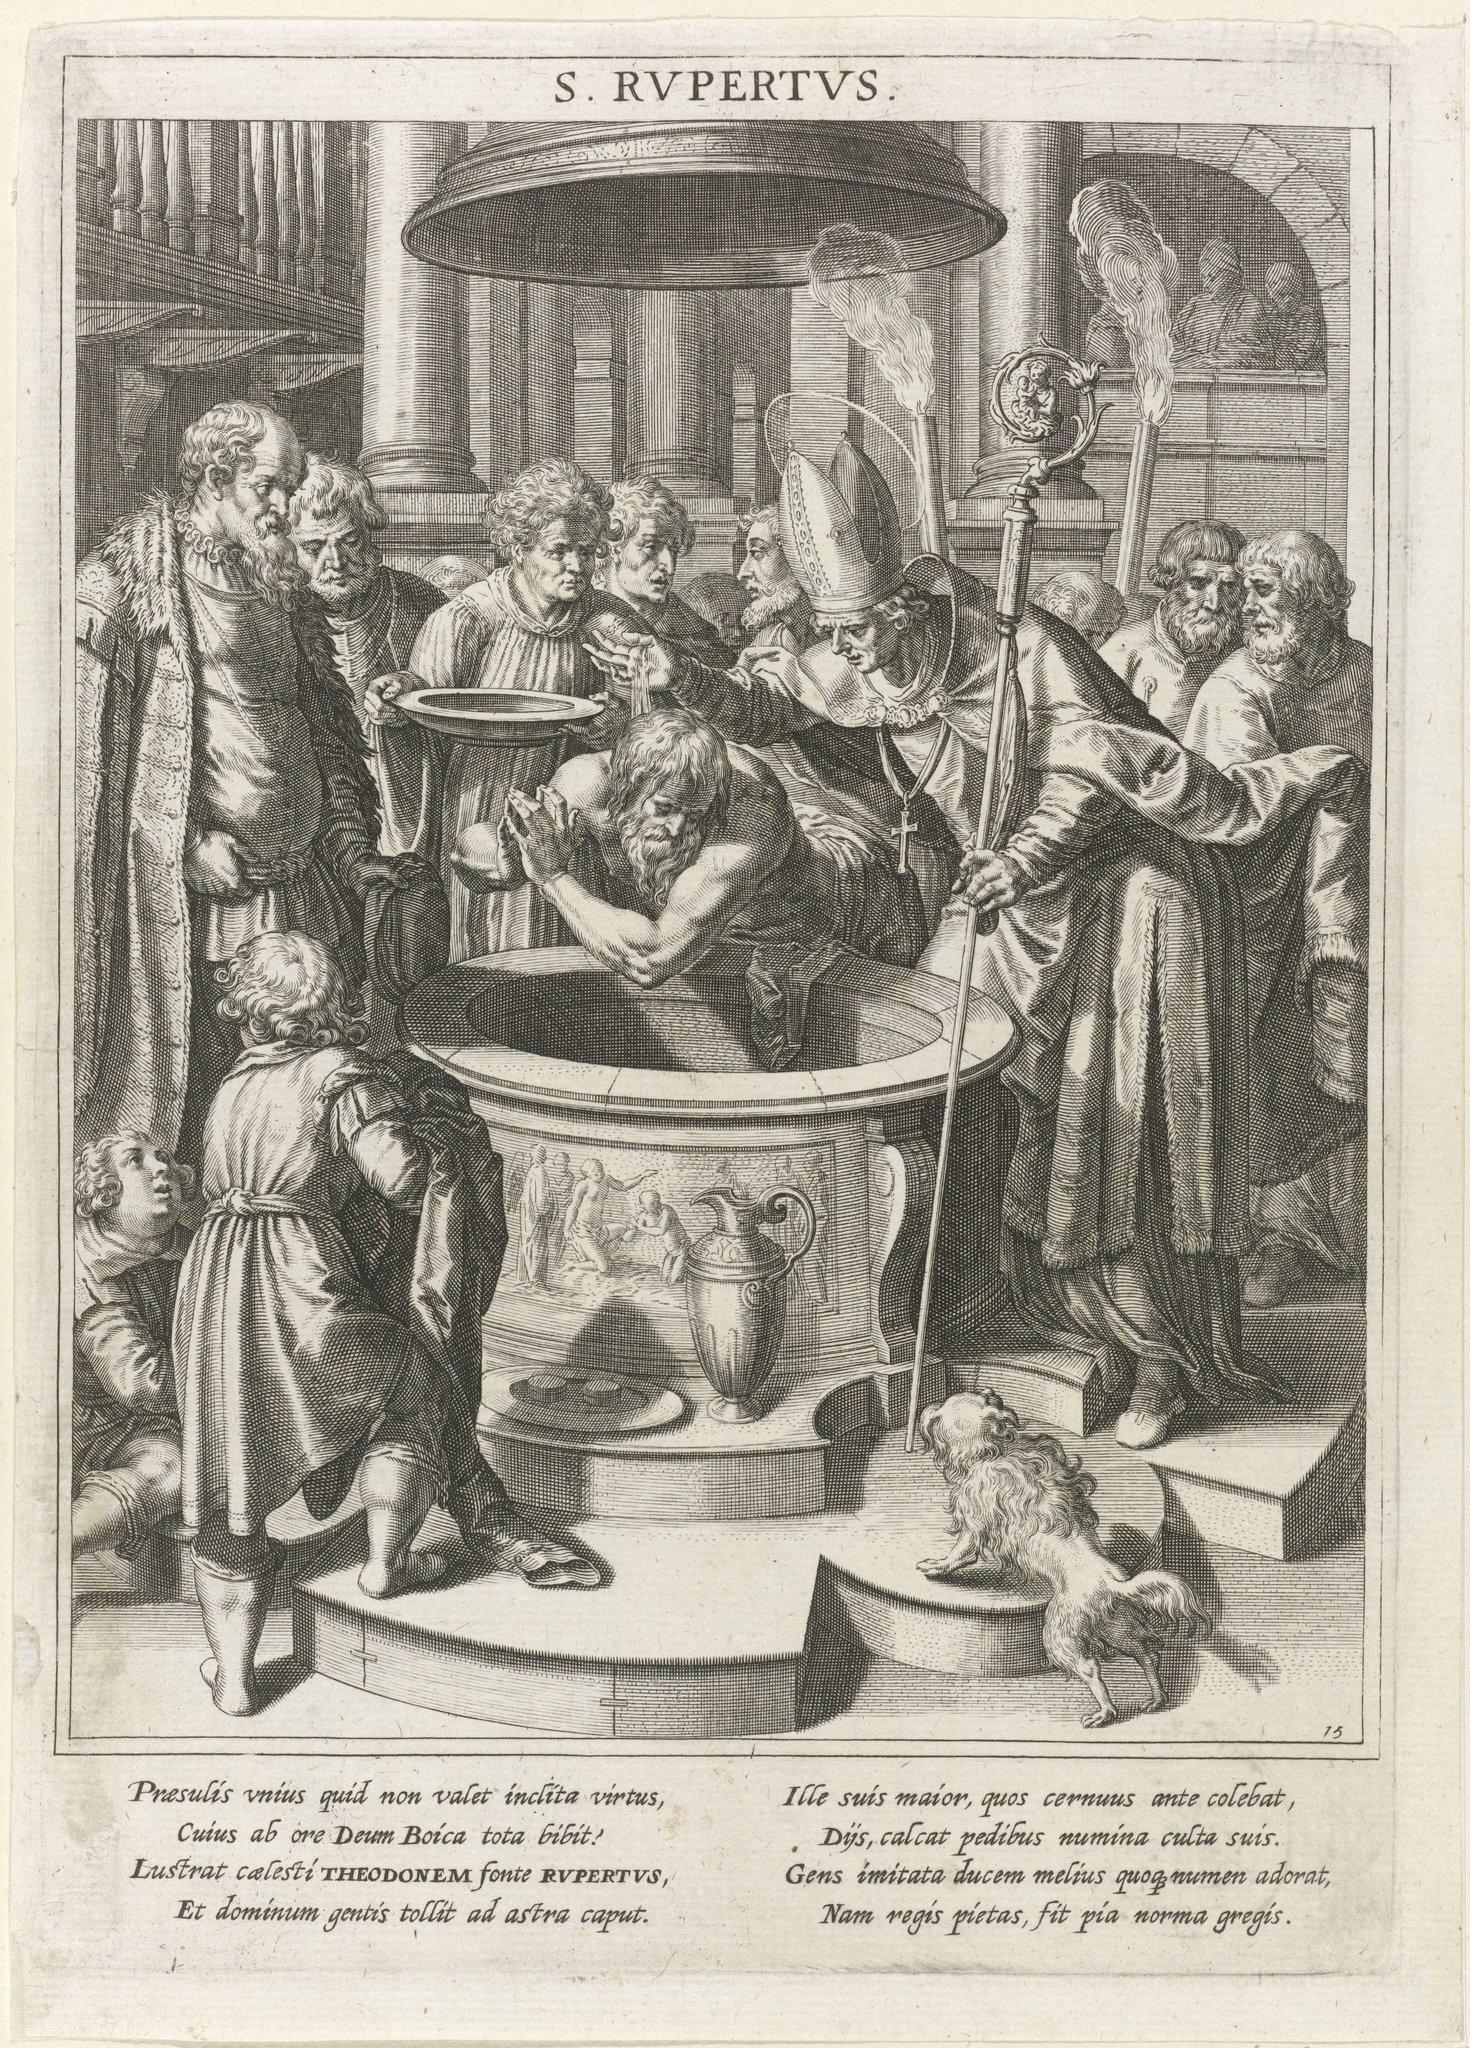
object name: print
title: Bavaria sancta I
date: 1615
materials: paper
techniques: engraving, etching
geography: munich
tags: male saints (with name), insignia of bishop, e.g. mitre, crozier, baptismal font, solemn baptism (by bishop or priest)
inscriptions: collector's mark: Lugt 240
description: De H. Rupertus, de eerste bisschop van Salzburg, staat naast een ornamenteel doopvond in een kerk en doopt een oude man. Achter hem staan andere inwoners van Salzburg. De prent heeft een Latijns onderschrift en is de vijftiende prent van een 60-delige serie met als onderwerp de heiligen van Beieren.